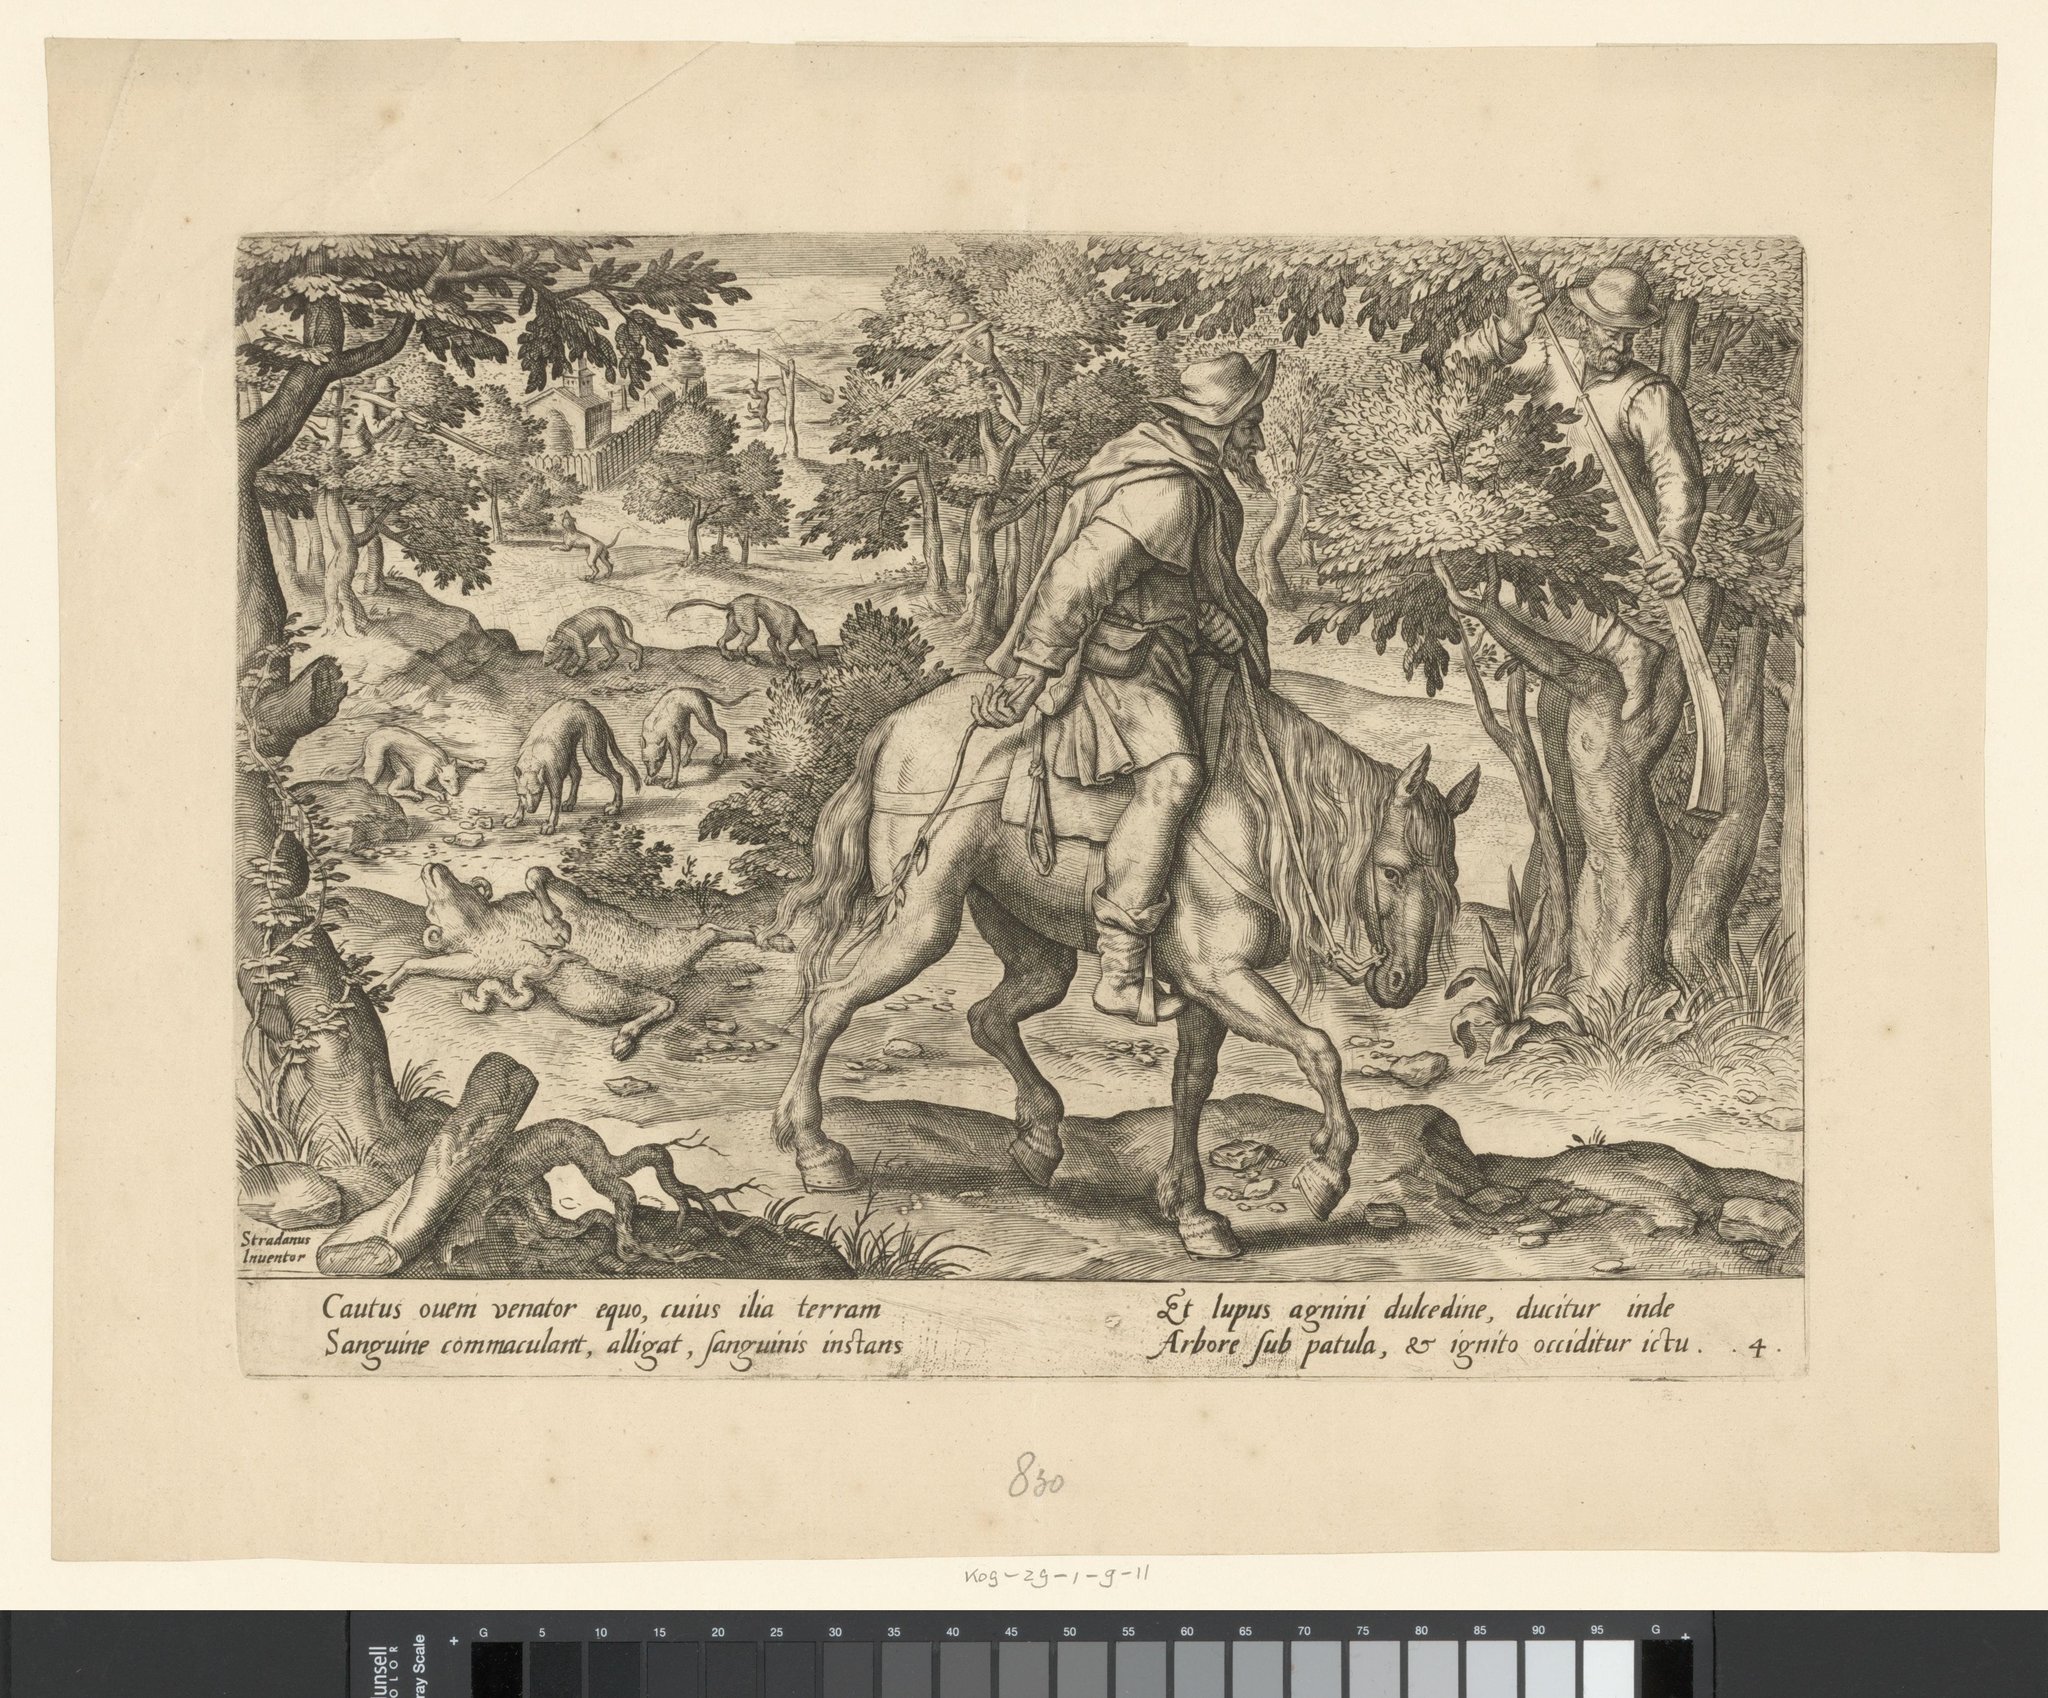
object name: print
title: Wolvenjacht met lokaas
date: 1567-1601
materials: paper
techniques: engraving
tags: hunt ~ predatory animals (fox, lion), hunters hunting (n.b.: in 1988-1990 this notation denoted the concept of 43c11421 'hunters resting during the hunt'), beasts of prey, predatory animals: wolf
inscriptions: stamp, collector's mark: Lugt 1641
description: Een man te paard sleept een dood schaap mee als lokaas voor de wolven. De poot van het schaap is vastgebonden aan de staart van het paard. Tussen het gebladerte van bomen zitten jagers met jachtgeweren verscholen om de wolven af te schieten. Onder de voorstelling een vierregelig vers in het Latijn. Onderwerpsrubrieken binnen de Atlas Zeden en Gewoonten: Handel, nijverheid en verkeer, jacht.